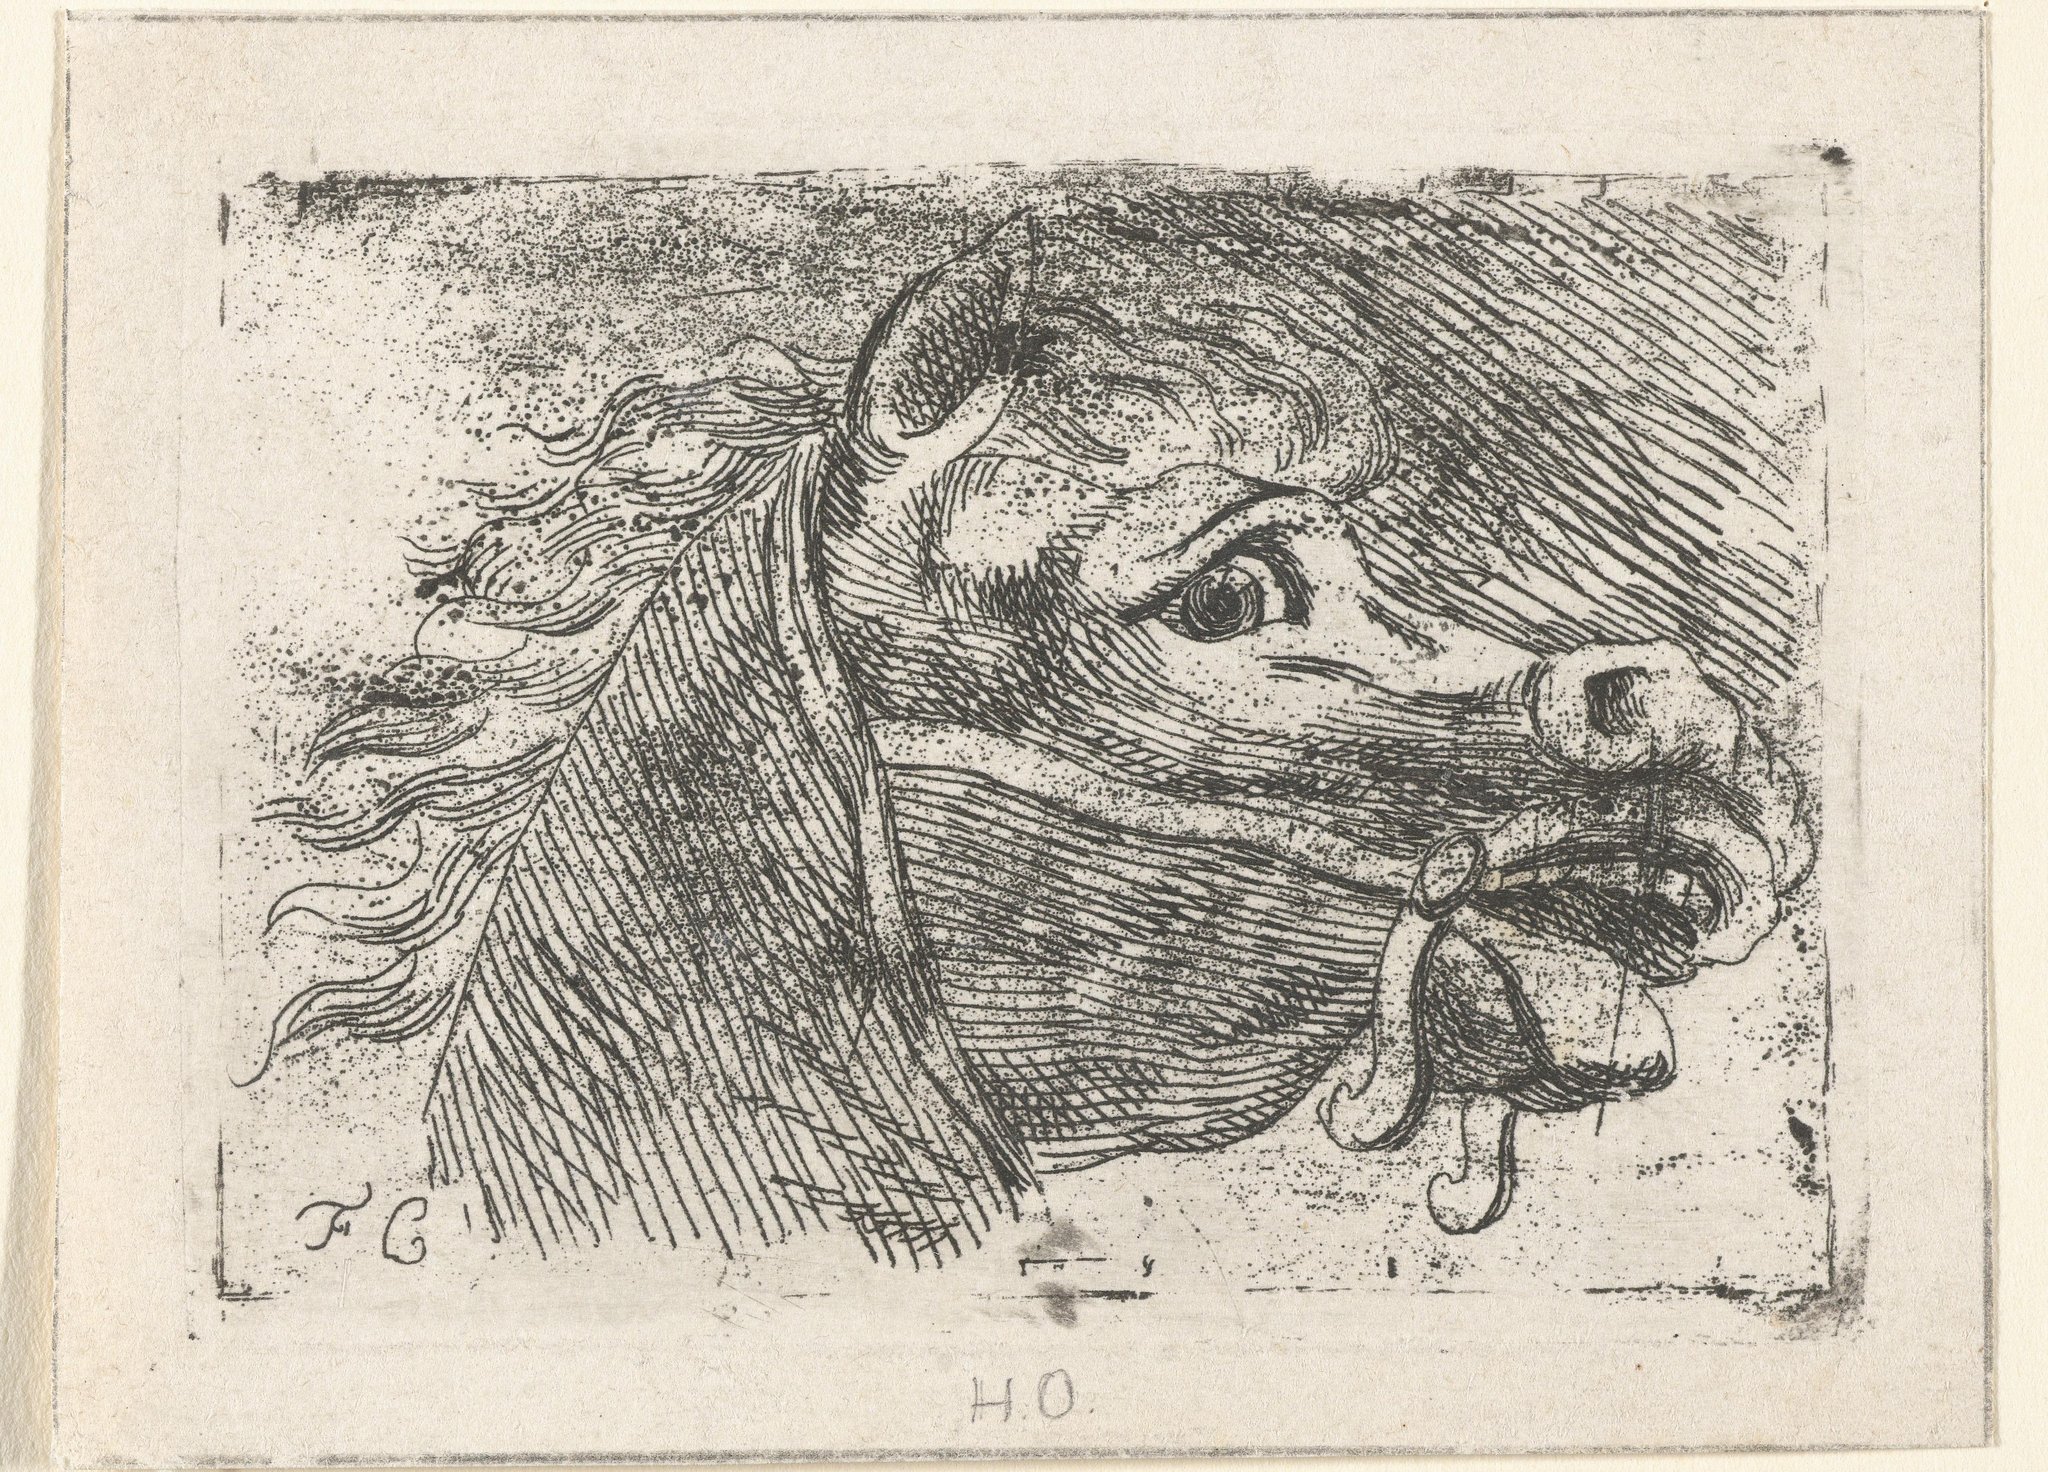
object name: print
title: Hoofd van een paard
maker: floris croese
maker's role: draughtsman, print maker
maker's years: 1763-1808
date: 1763-1808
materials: paper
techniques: etching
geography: amsterdam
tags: horse (+ head of an animal)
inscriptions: collector's mark: Lugt 2228